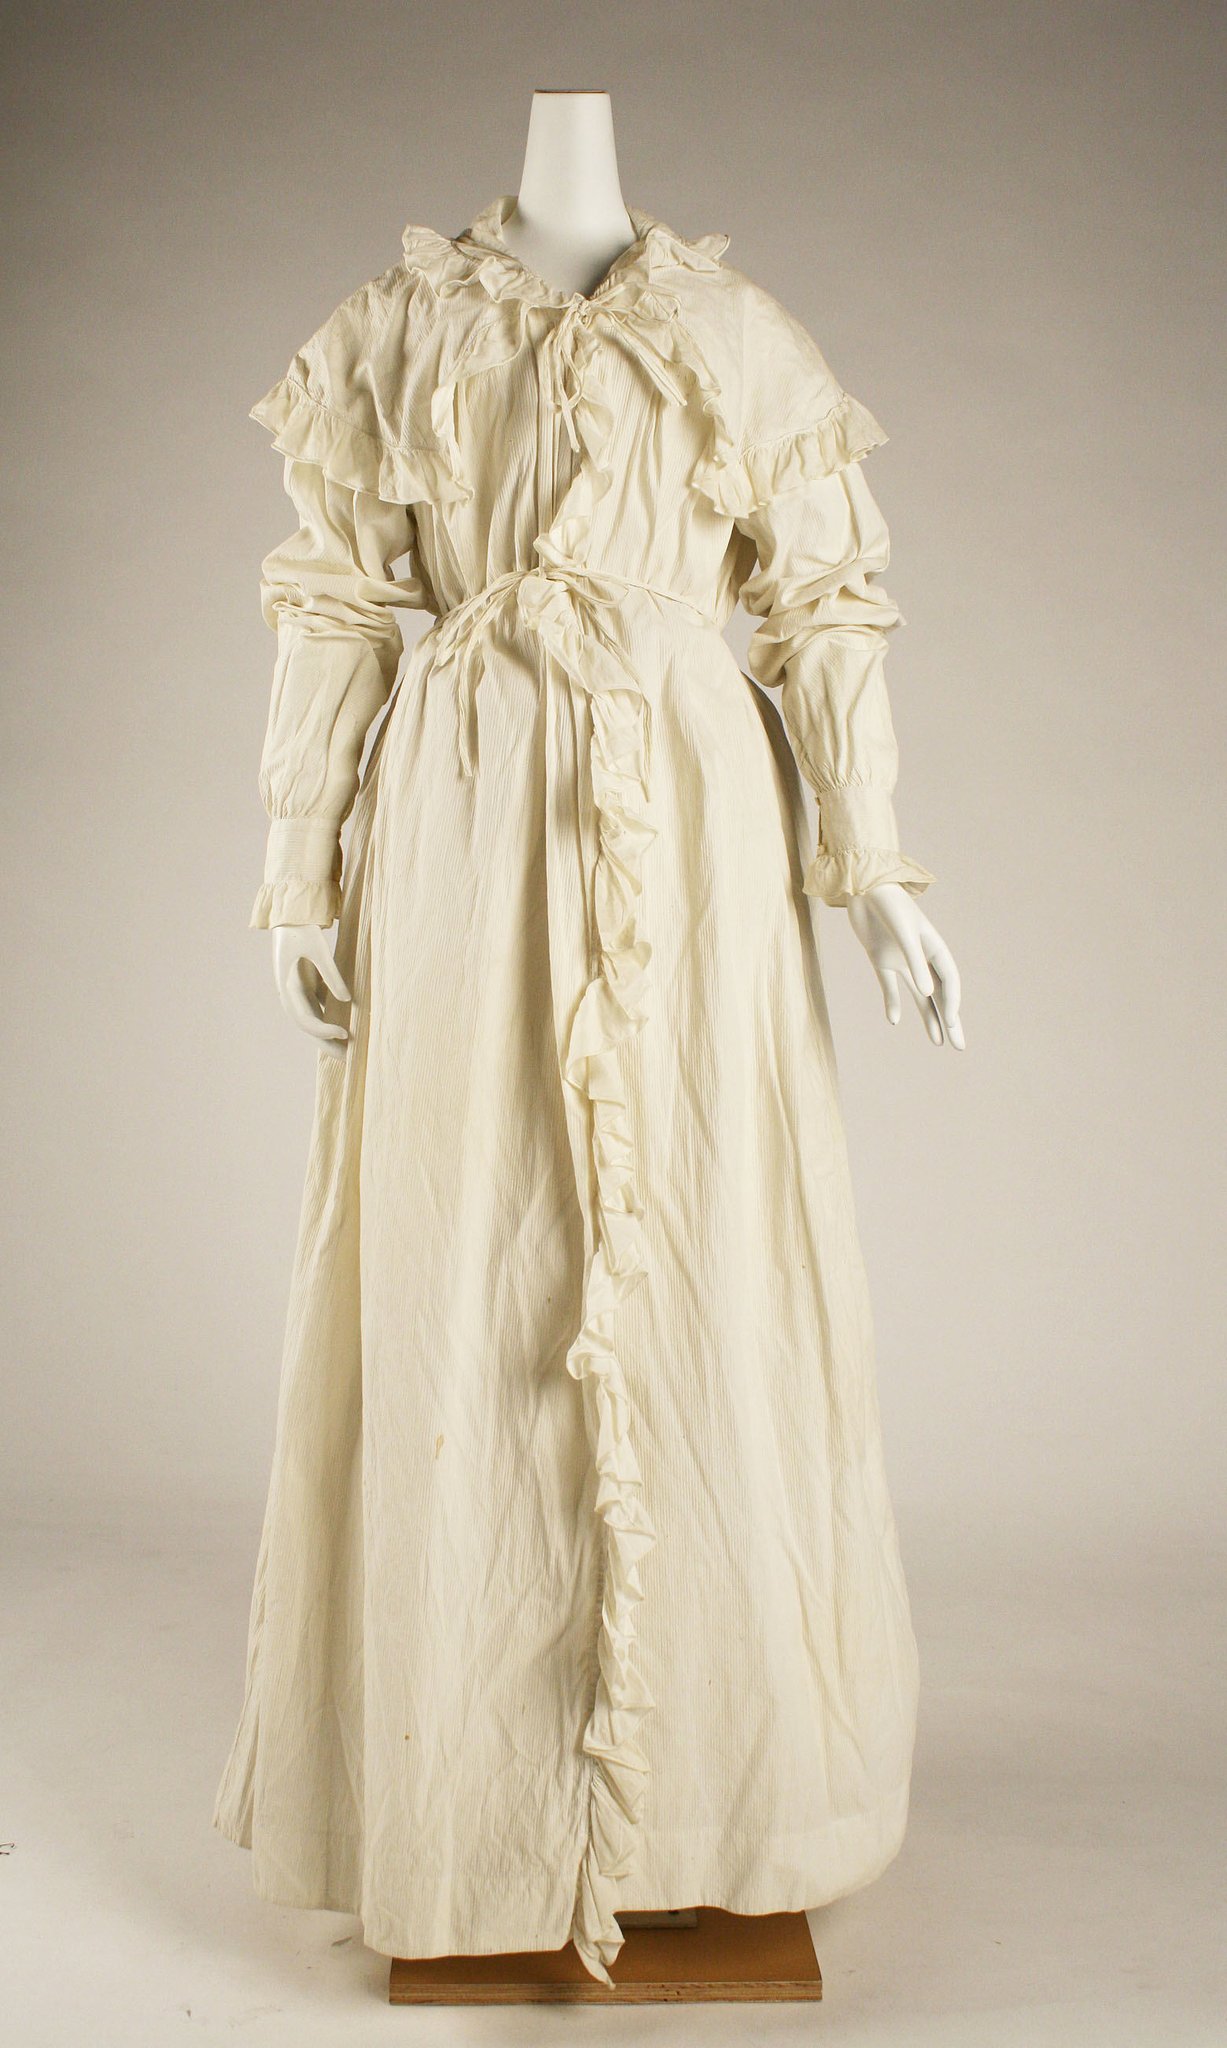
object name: peignoir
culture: british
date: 1821-1823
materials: cotton